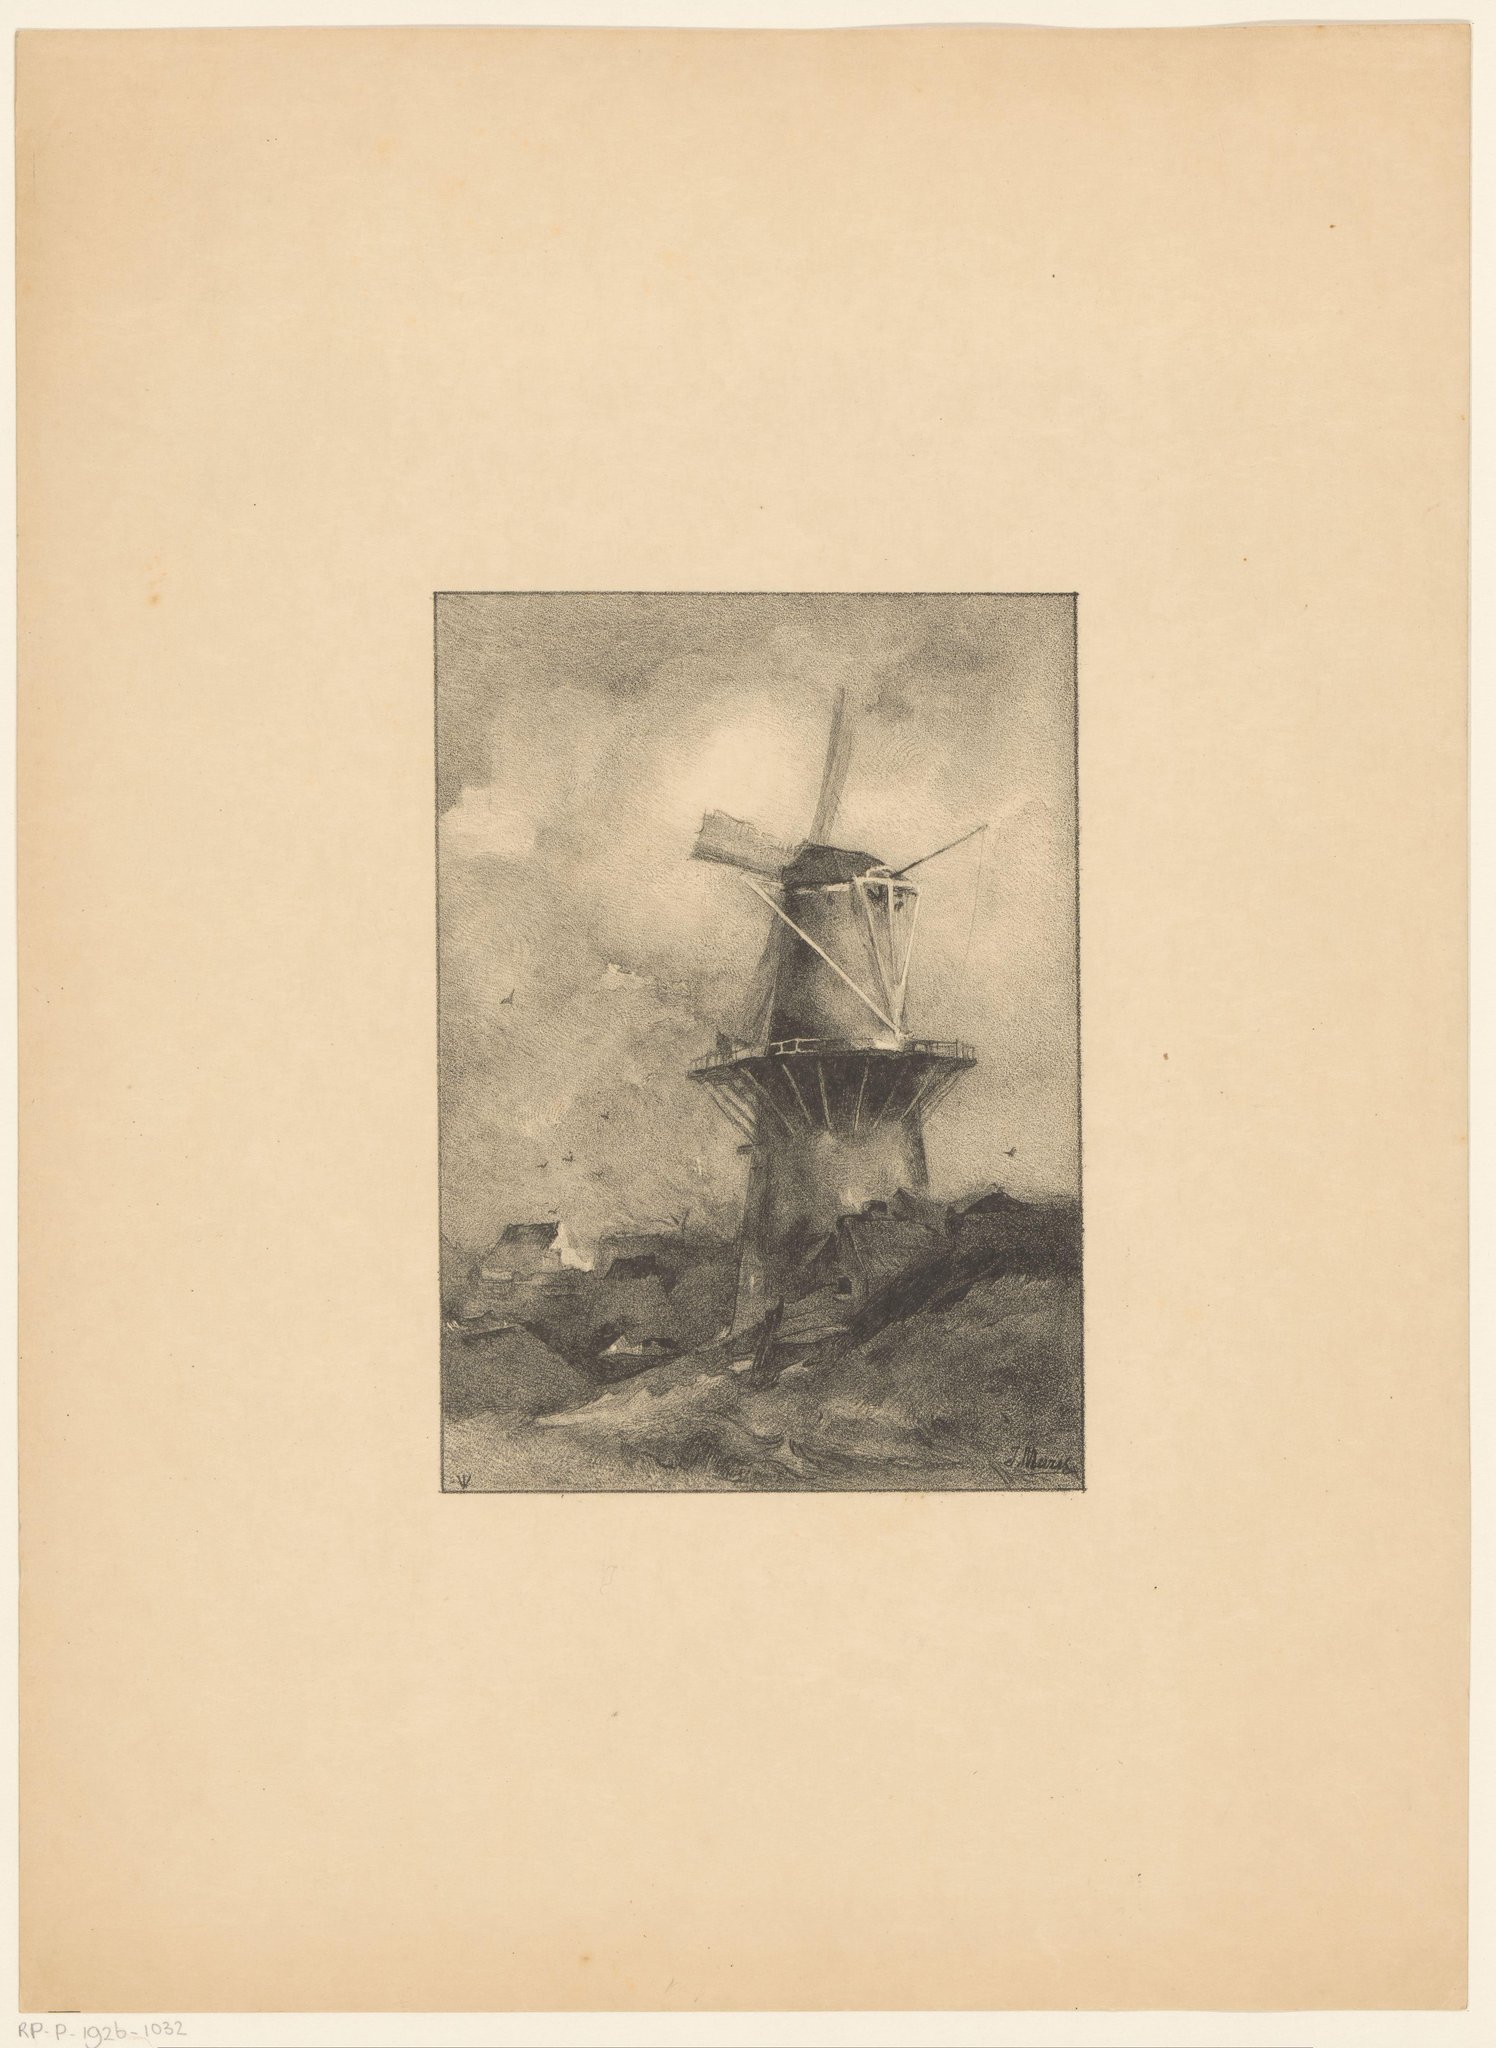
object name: print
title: Molen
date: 1880-1900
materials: paper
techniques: lithograph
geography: netherlands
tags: windmill in landscape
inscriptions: collector's mark: Lugt 2228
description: Een stenen molen in een landschap met huizen in de achtergrond.